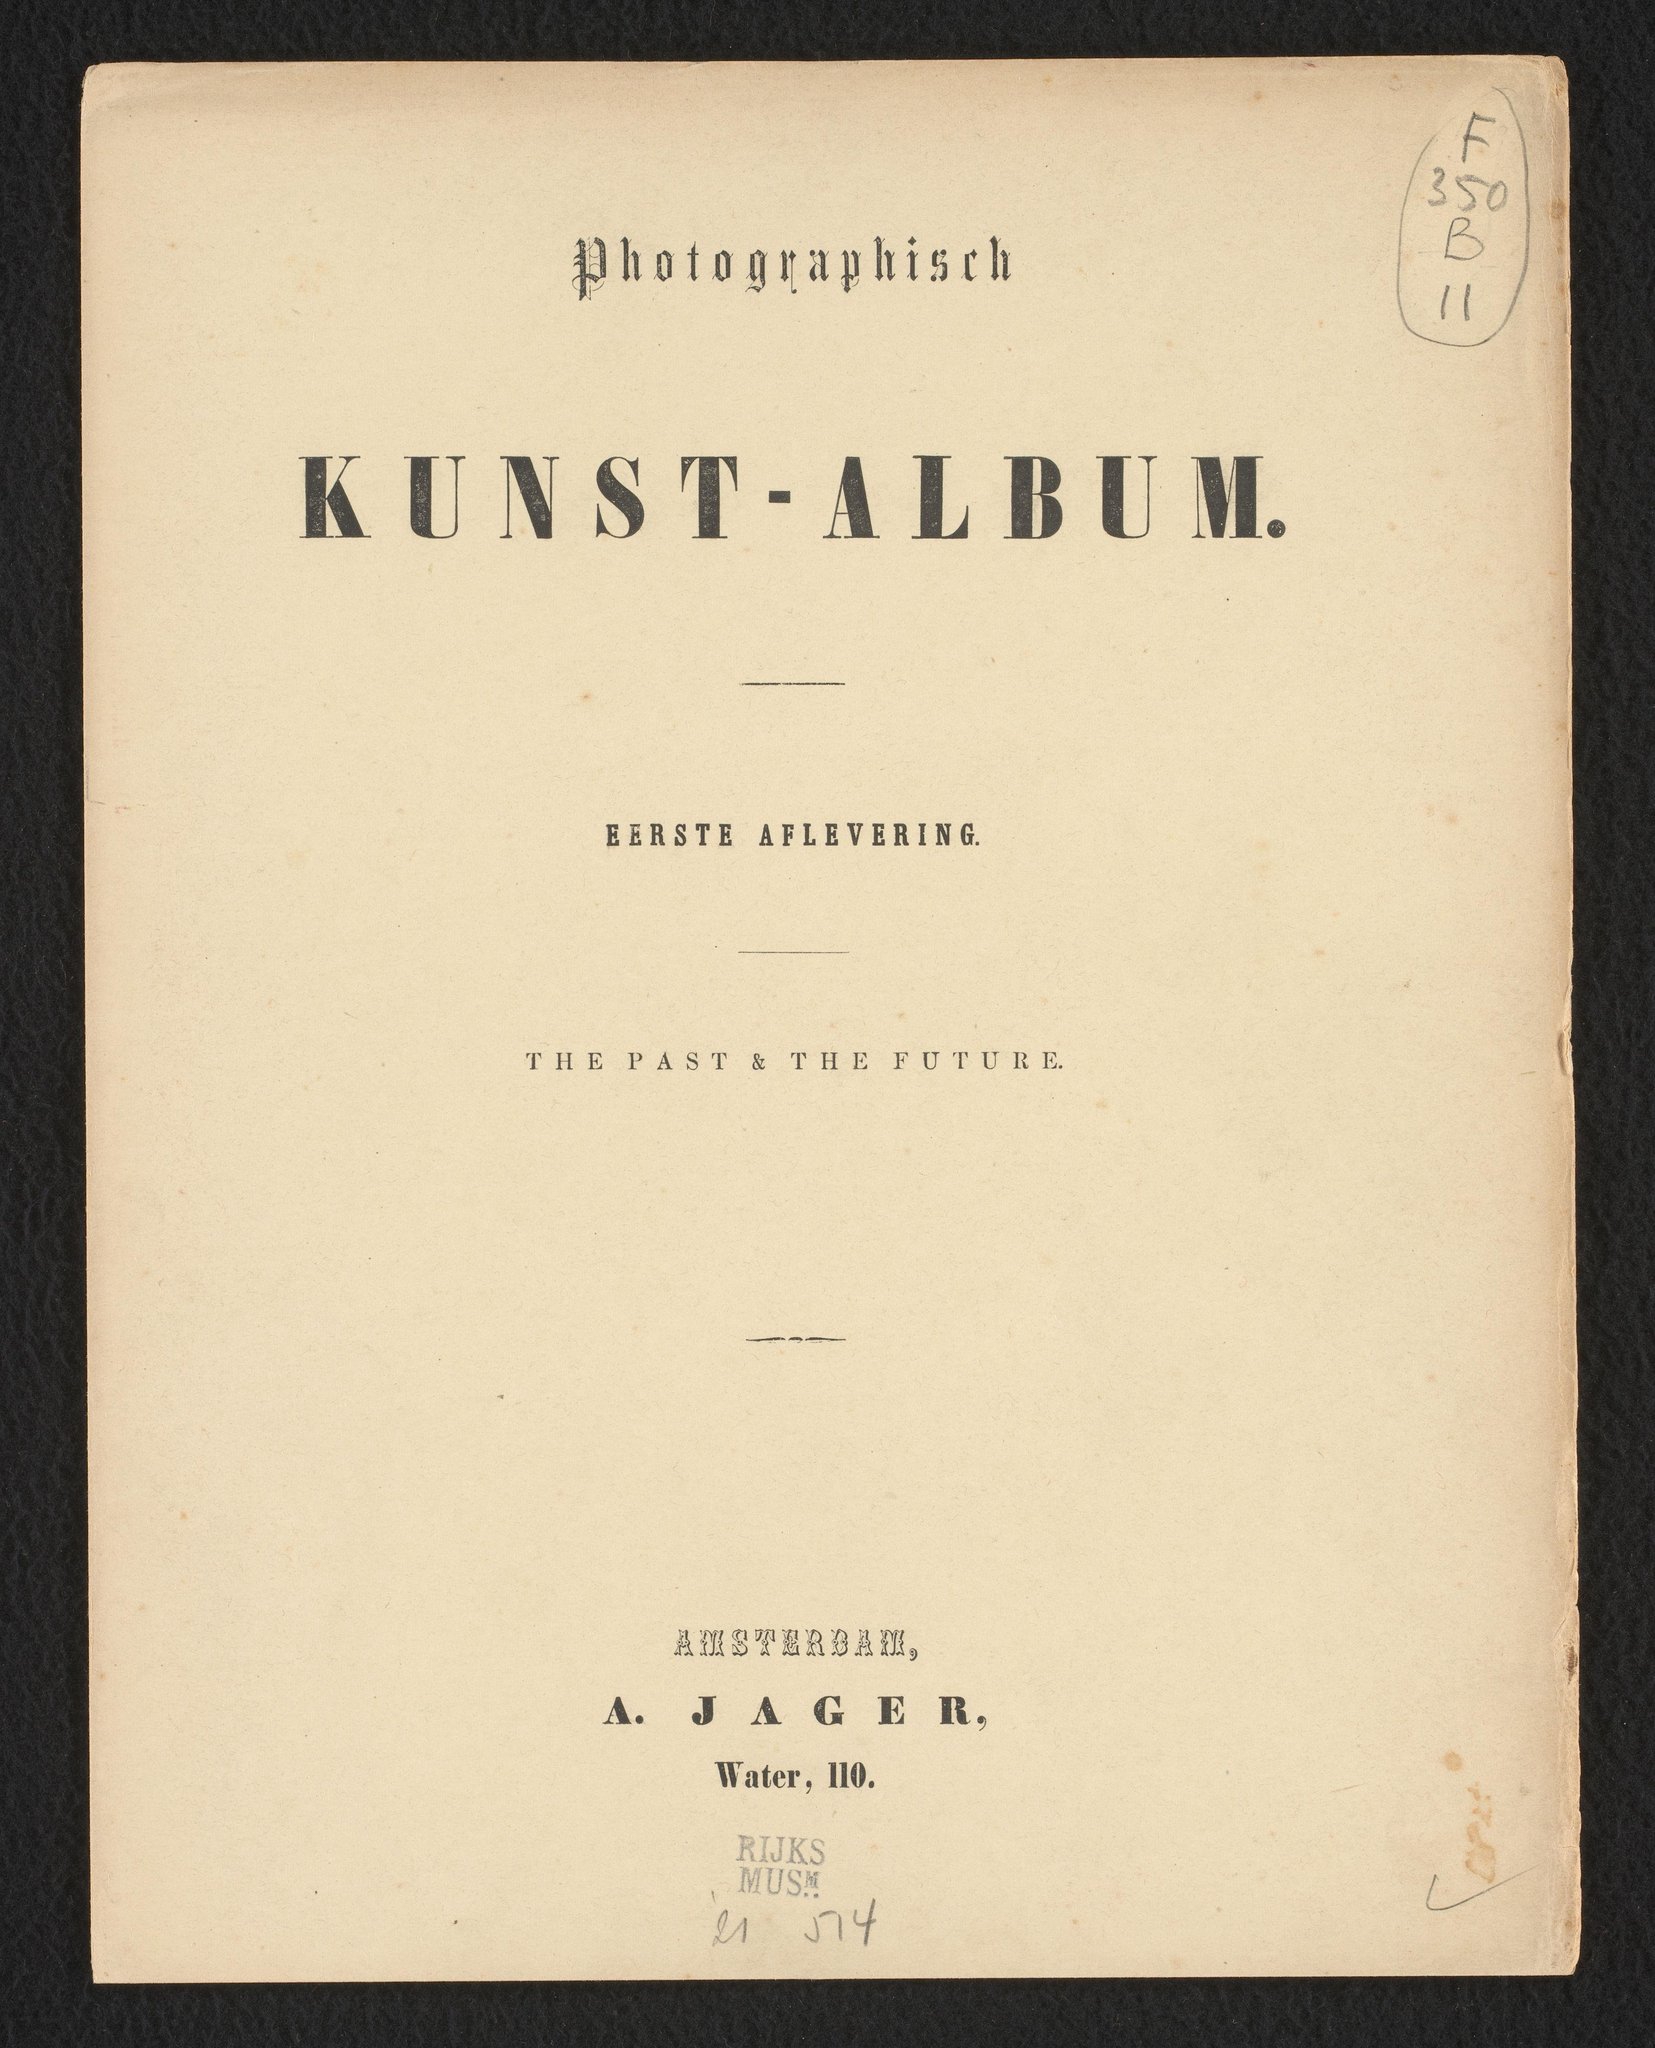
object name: wrapper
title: Omslag voor een fotoreproductie van het schilderij The Past & The Future naar Margareth Gillies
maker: andries jager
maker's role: publisher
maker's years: 1825-1905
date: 1860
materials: paper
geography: amsterdam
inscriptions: stamp: ‘RIJKS/ MUSM’, number: ‘21 514’, inscription: ‘Photographisch/ KUNST-ALBUM./ EERSTE AFLEVERING./ THE PAST & THE FUTURE./ AMSTERDAM,/ A. JAGER,/ Water, 110.’, inscription: ‘THE PAST & THE FUTURE./ NAAR EENE SCHILDERIJ/ VAN/ MISS MARGARETH GILLIES.’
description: Deze omslag maakt deel uit van een omslag met twaalf fotoreproducties, maar bevat geen foto.